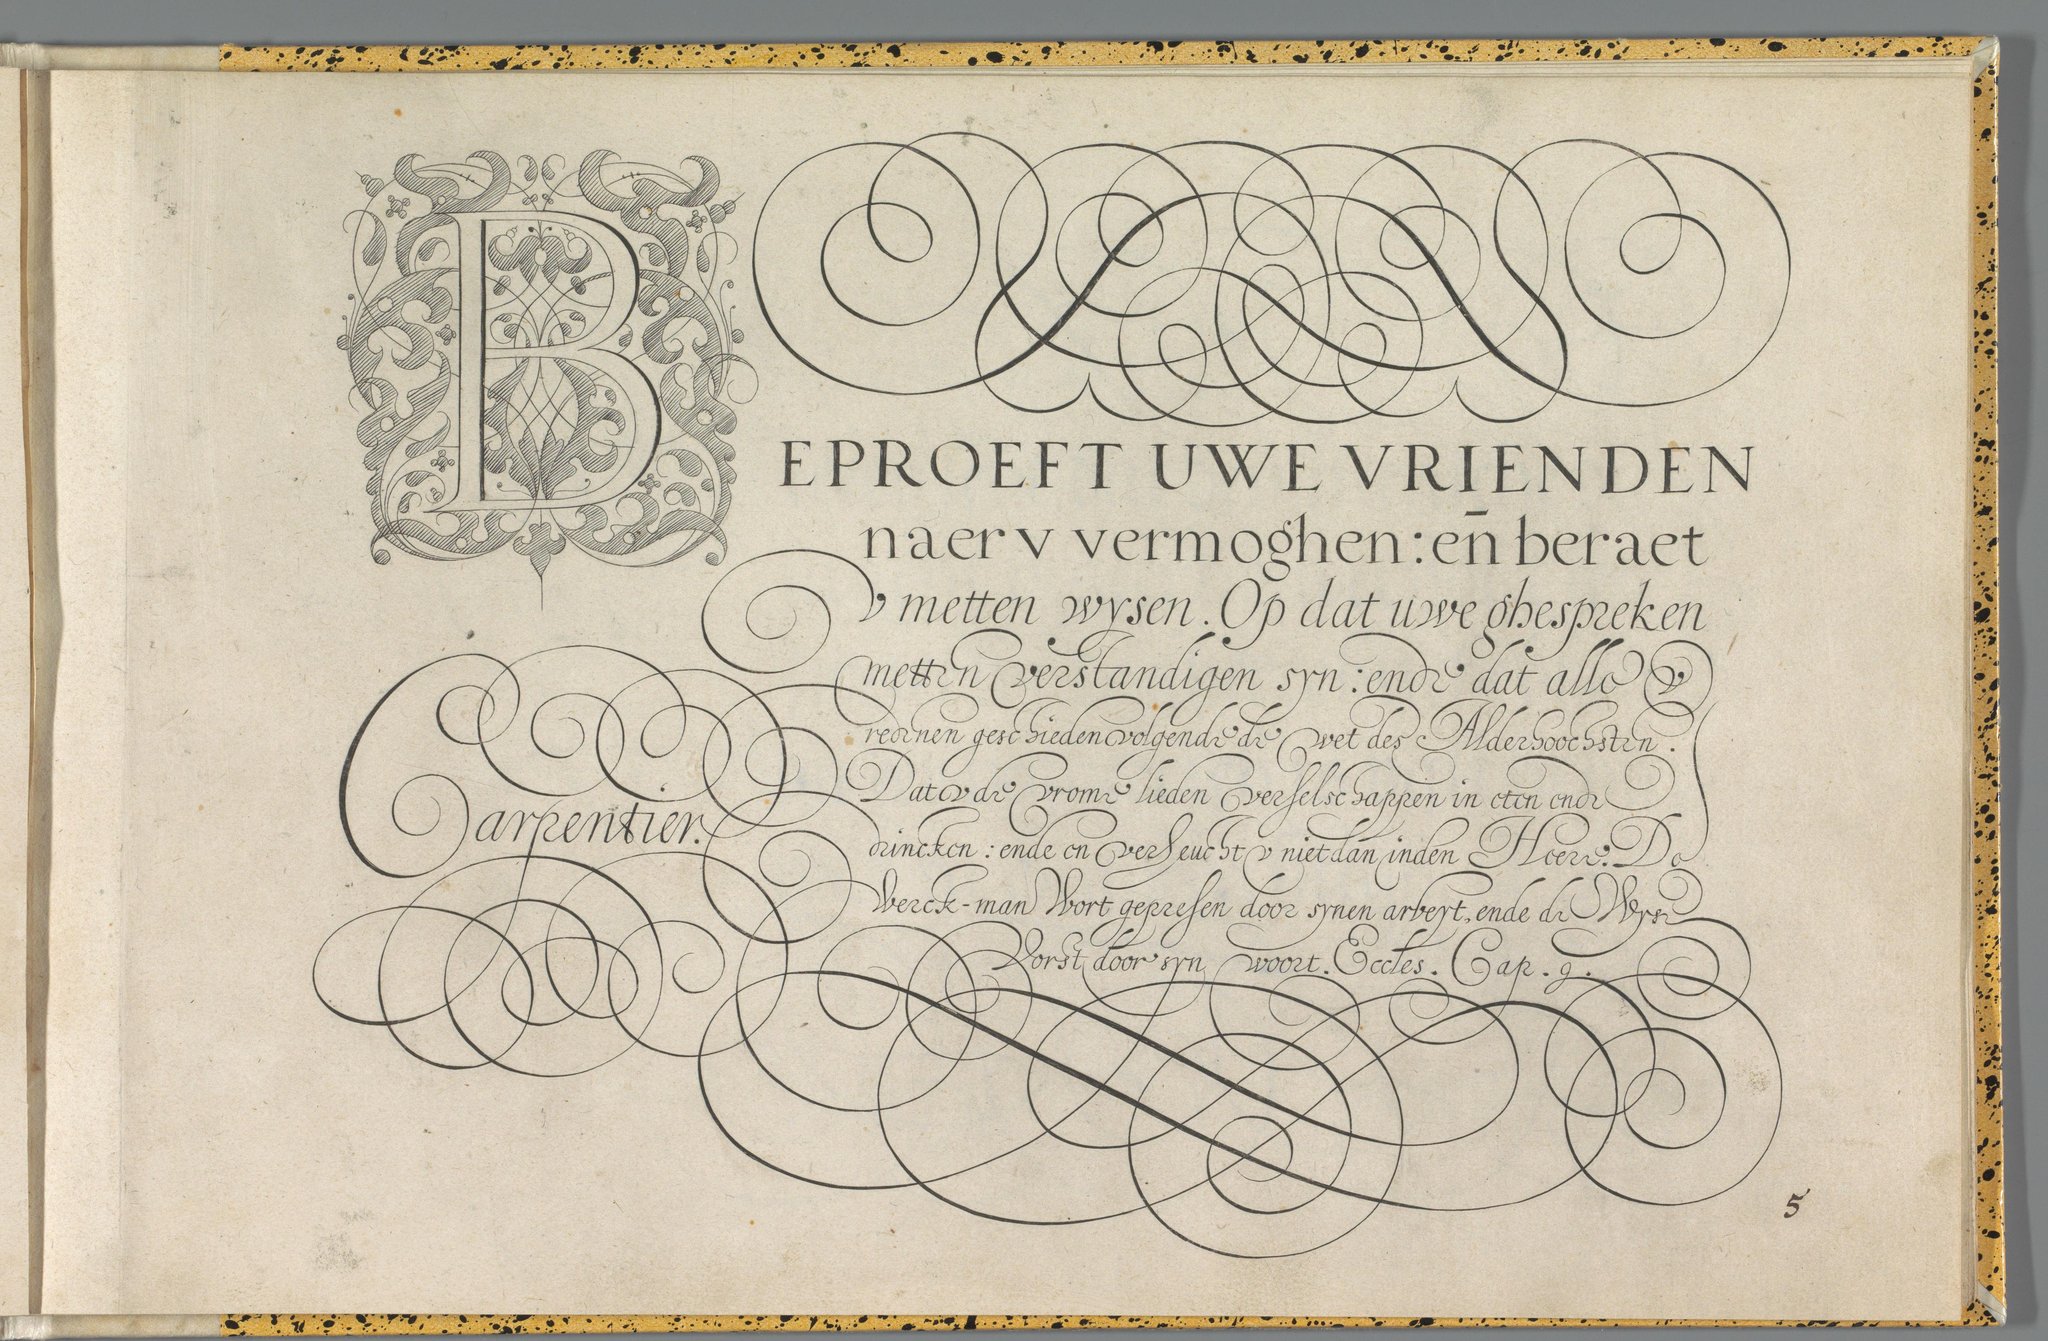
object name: album leaf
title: Exemplaer-Boeck. Inhoudende d'alder-gebruyckelyckste Geschriften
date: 1618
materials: paper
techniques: engraving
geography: amsterdam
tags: calligraphy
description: Schrijfvoorbeeld met de tekst: Beproeft uwe vrienden (...). Deze prent maakt deel uit van een album.